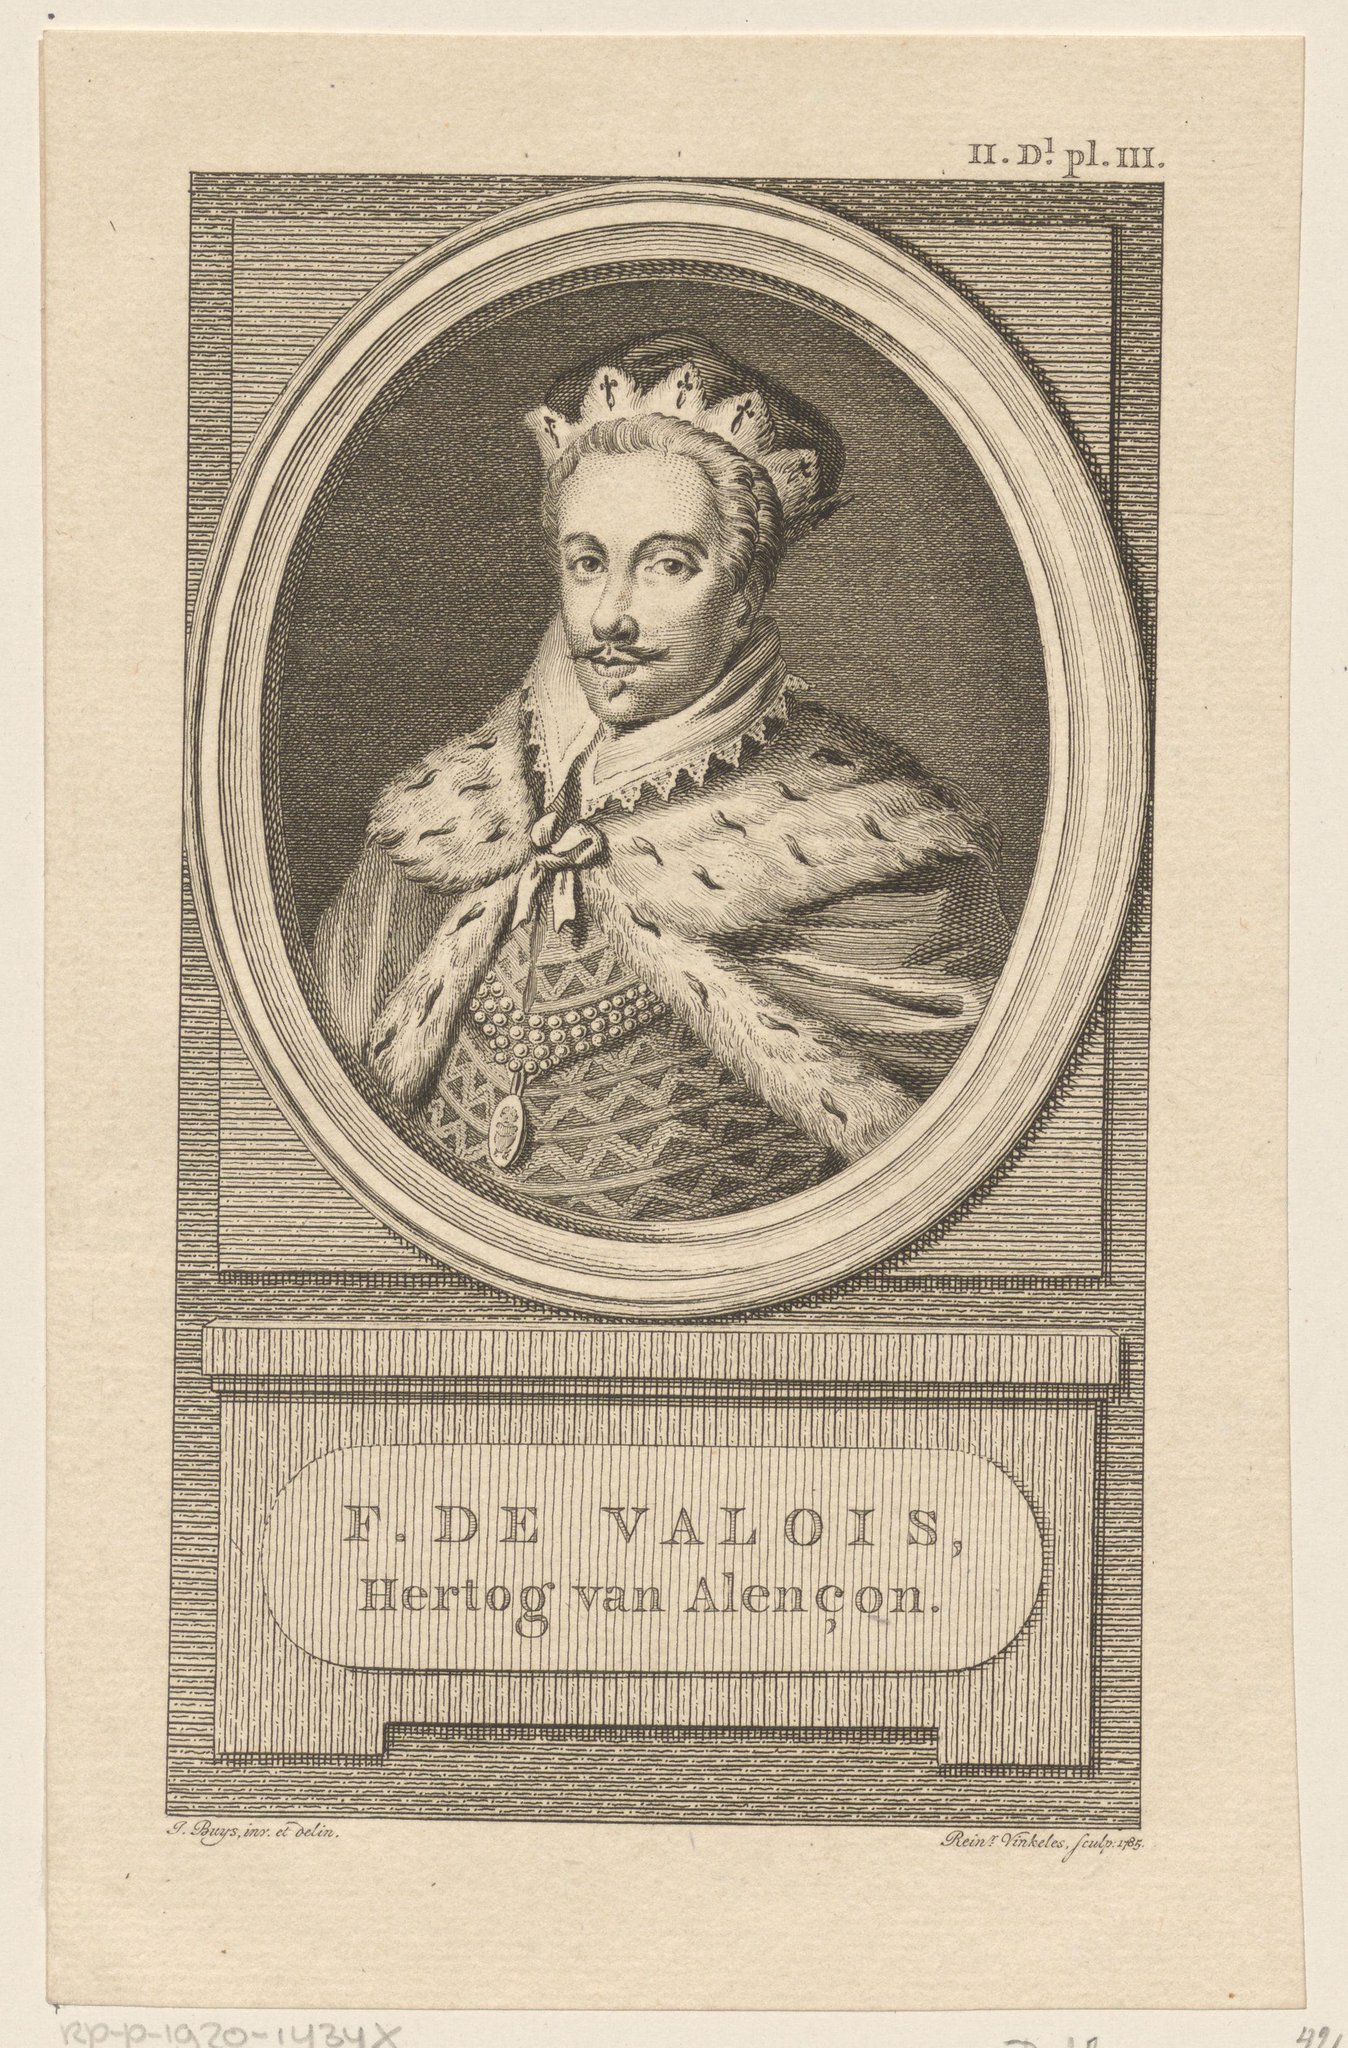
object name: print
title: Portret van François-Hercule de Valois, hertog van Anjou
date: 1785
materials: paper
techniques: engraving, etching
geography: amsterdam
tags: françois-hercule de valois (hertog van anjou)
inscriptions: collector's mark: Lugt 2228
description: Prent uit: Kok, Jacobus. Vaderlandsch woordenboek : met kaarten, plaaten en pourtraitten. Amsterdam: Johannes Allart, 1785-1796.